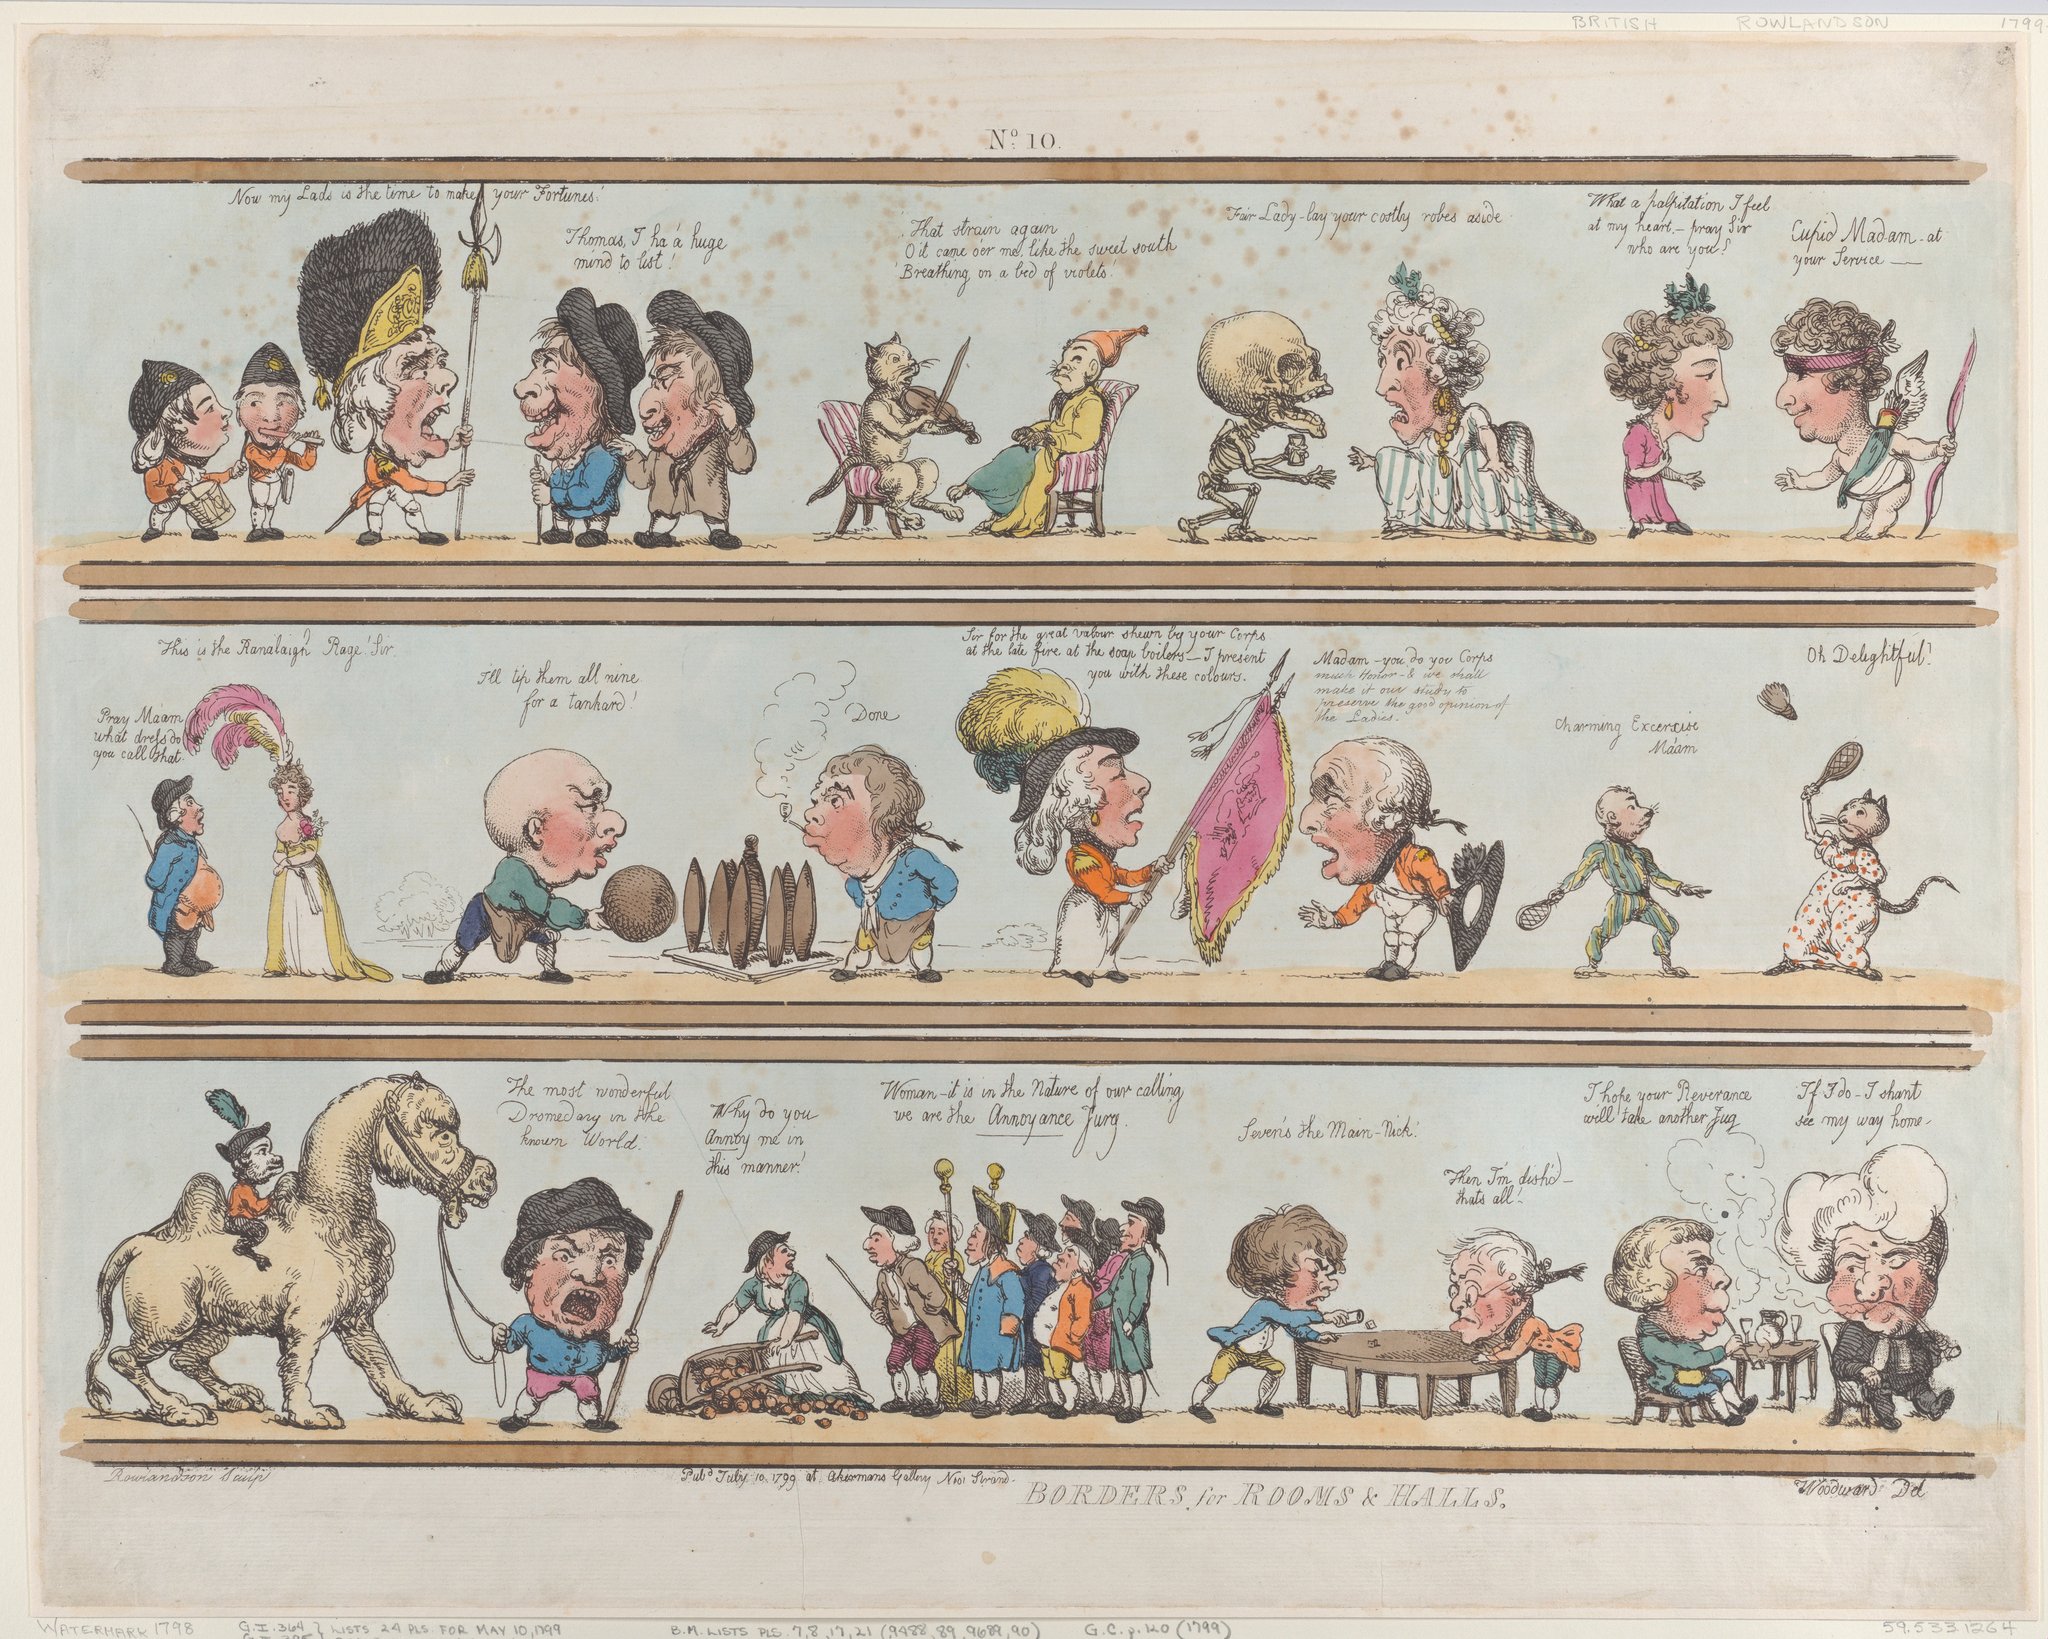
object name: print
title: Borders for Rooms & Halls, Plate 10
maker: thomas rowlandson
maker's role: artist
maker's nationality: british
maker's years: 1757-1827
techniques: etching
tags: satire,men,women,camels,cats